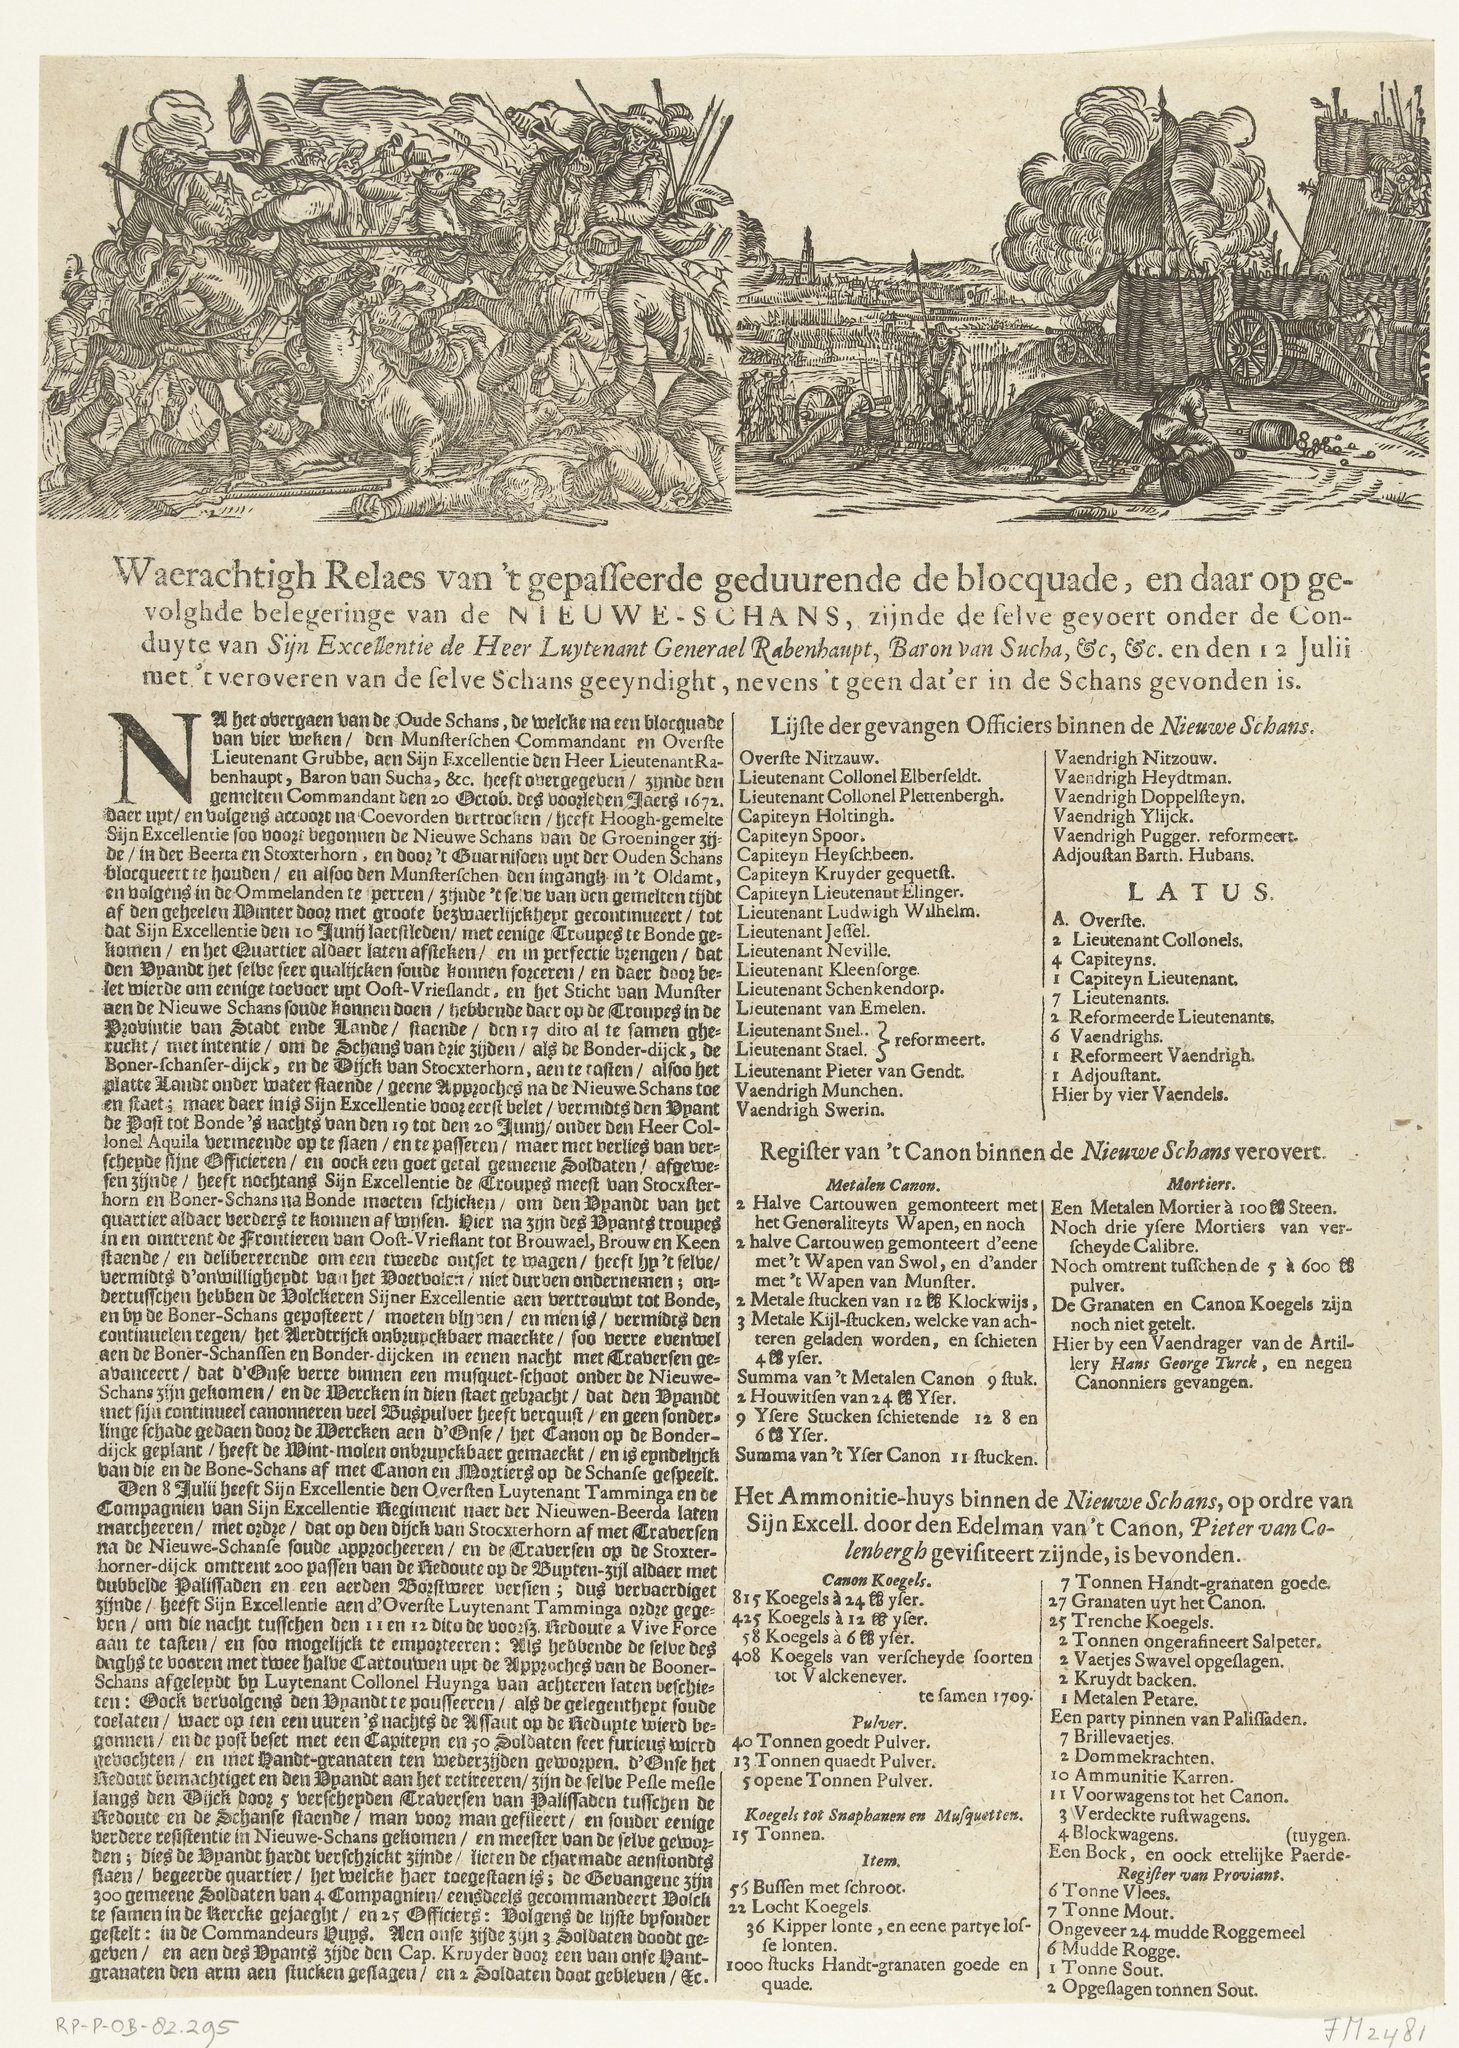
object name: print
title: De verovering van Nieuweschans, 1673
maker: Anonymous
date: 1673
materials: paper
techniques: letterpress printing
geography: northern netherlands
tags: siege, position war, battle (+ land forces)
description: Verovering van Nieuweschans door de Staatse troepen onder Rabenhaupt op het Bisschoppelijke leger in de nacht van 21 op 22 juli 1673. Deze gebeurtenissen worden geïllustreerd met twee fragmenten van oude houtsneden met militaire voorstellingen. Hieronder een beschrijving van de inname, een lijst van officieren en de ammunitie aangetroffen in de vesting.